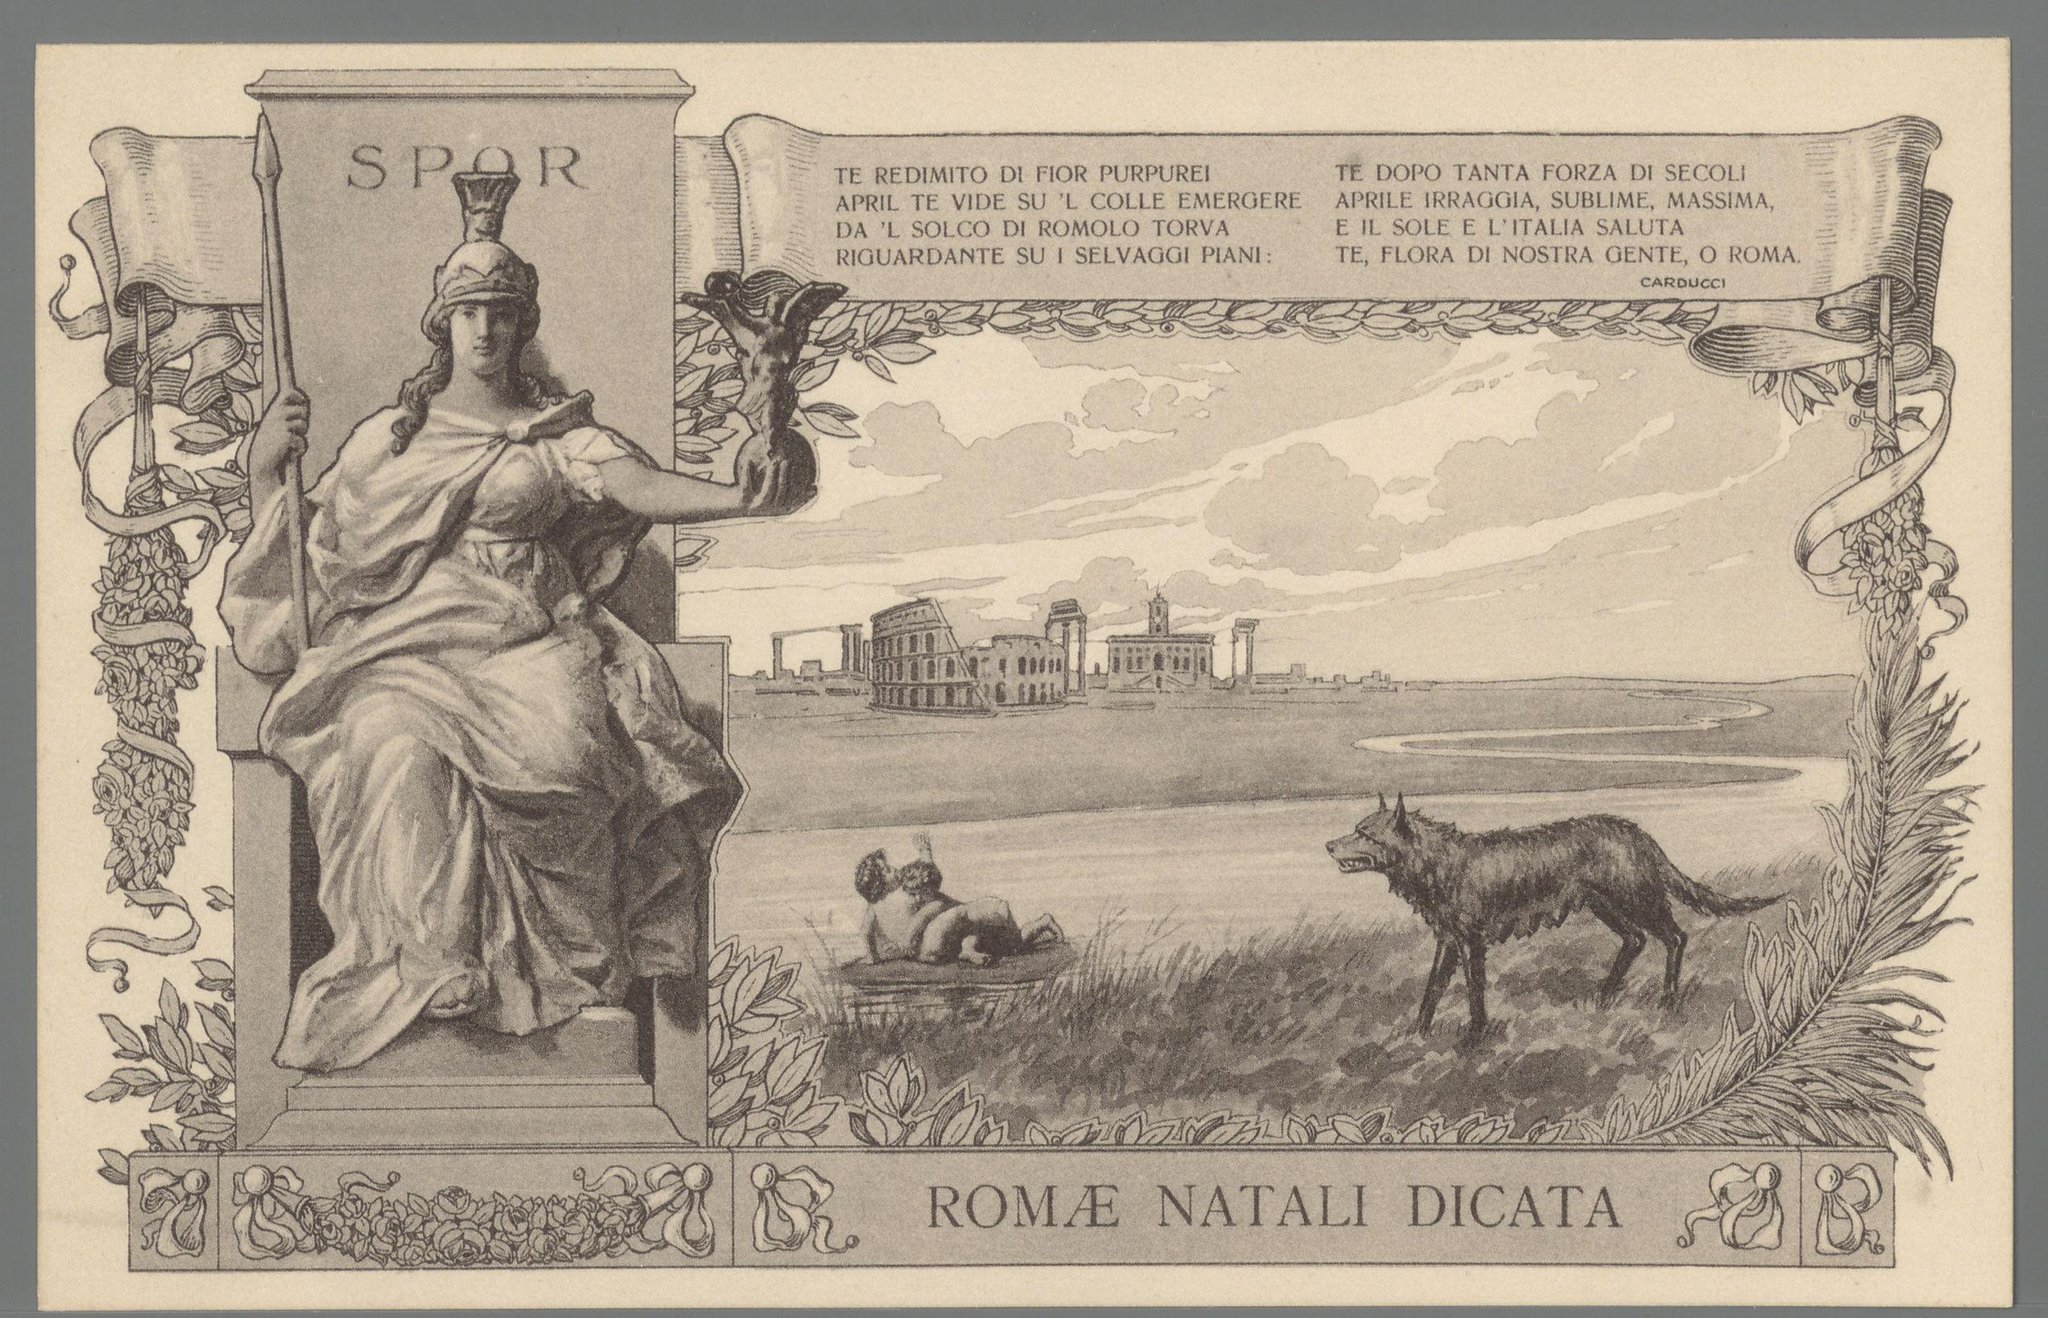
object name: ansichtkaart, prentbriefkaart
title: Romae Natali Dicata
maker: Anonymous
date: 1906-1920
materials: cardboard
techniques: photograph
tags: river, temple, shrine ~ roman religion, beasts of prey, predatory animals: wolf